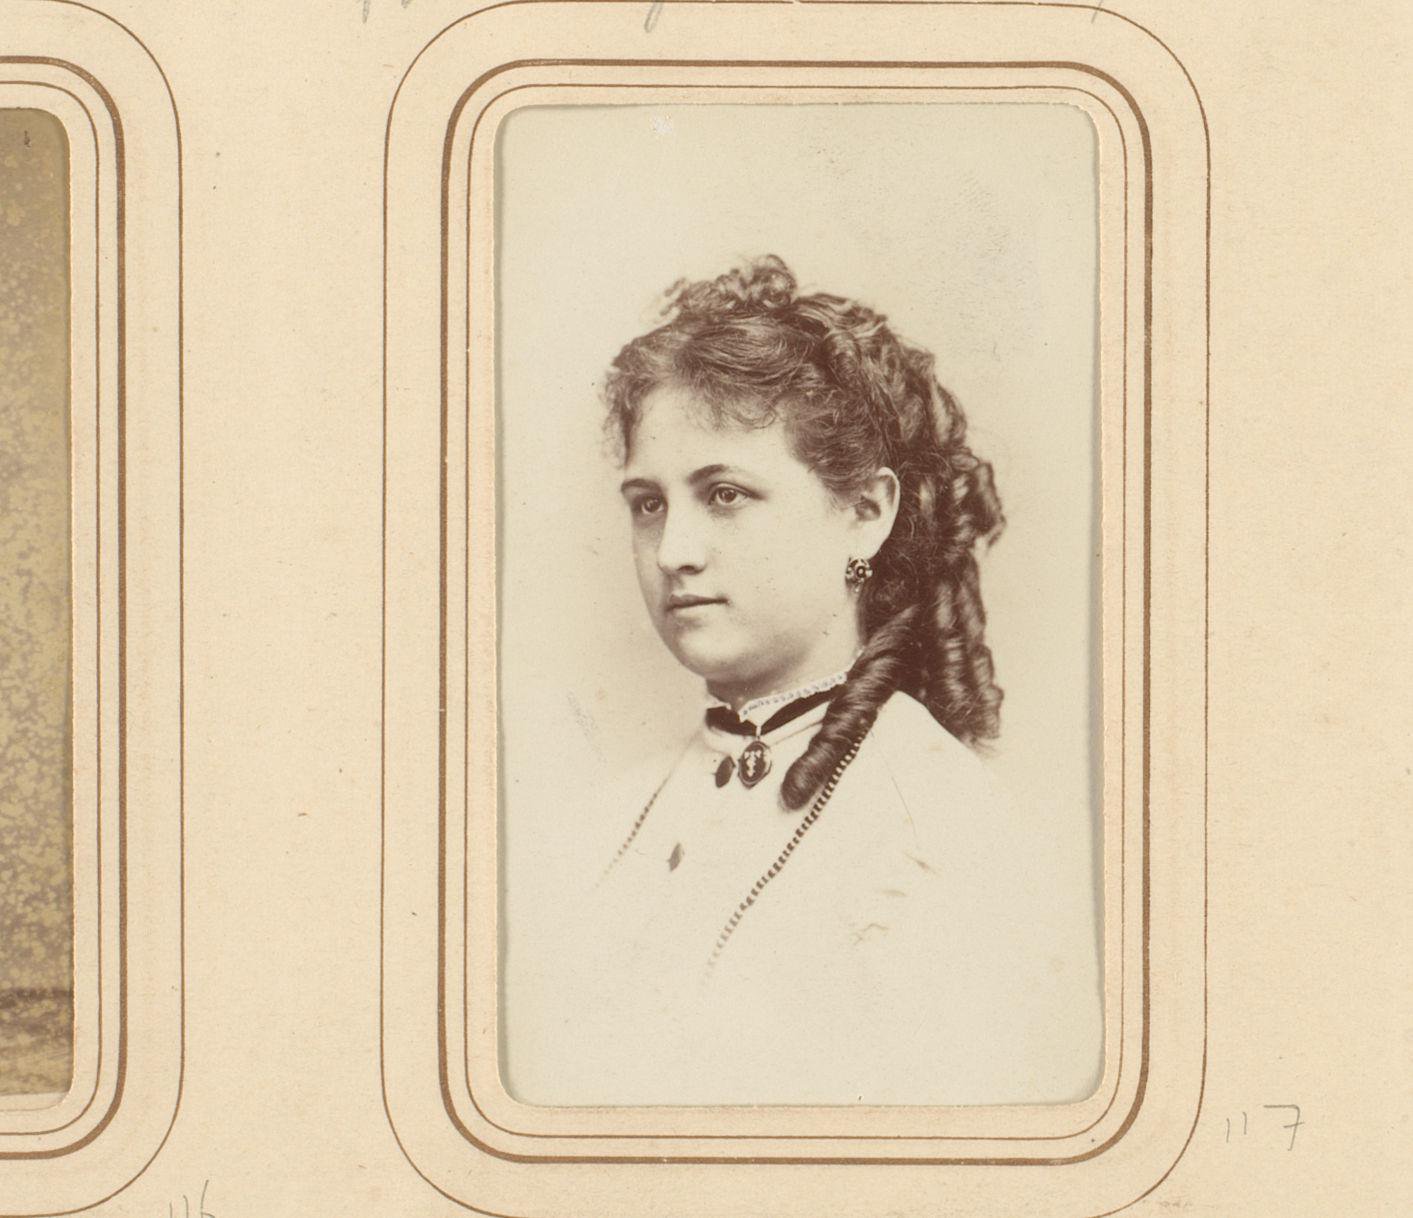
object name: album leaf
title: Portret van een vrouw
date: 1865-1890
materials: cardboard, photographic support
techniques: albumen print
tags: adult woman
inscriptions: inscription: ‘Photogr Atellier/ van/ Wegner & Mottu/ Kalverstraat D 36/ Amsterdam/ Leijdschestraatweg buiten Cathrijnen’, inscription: ‘Wegner & Mottu Amsterdam-Utrecht’